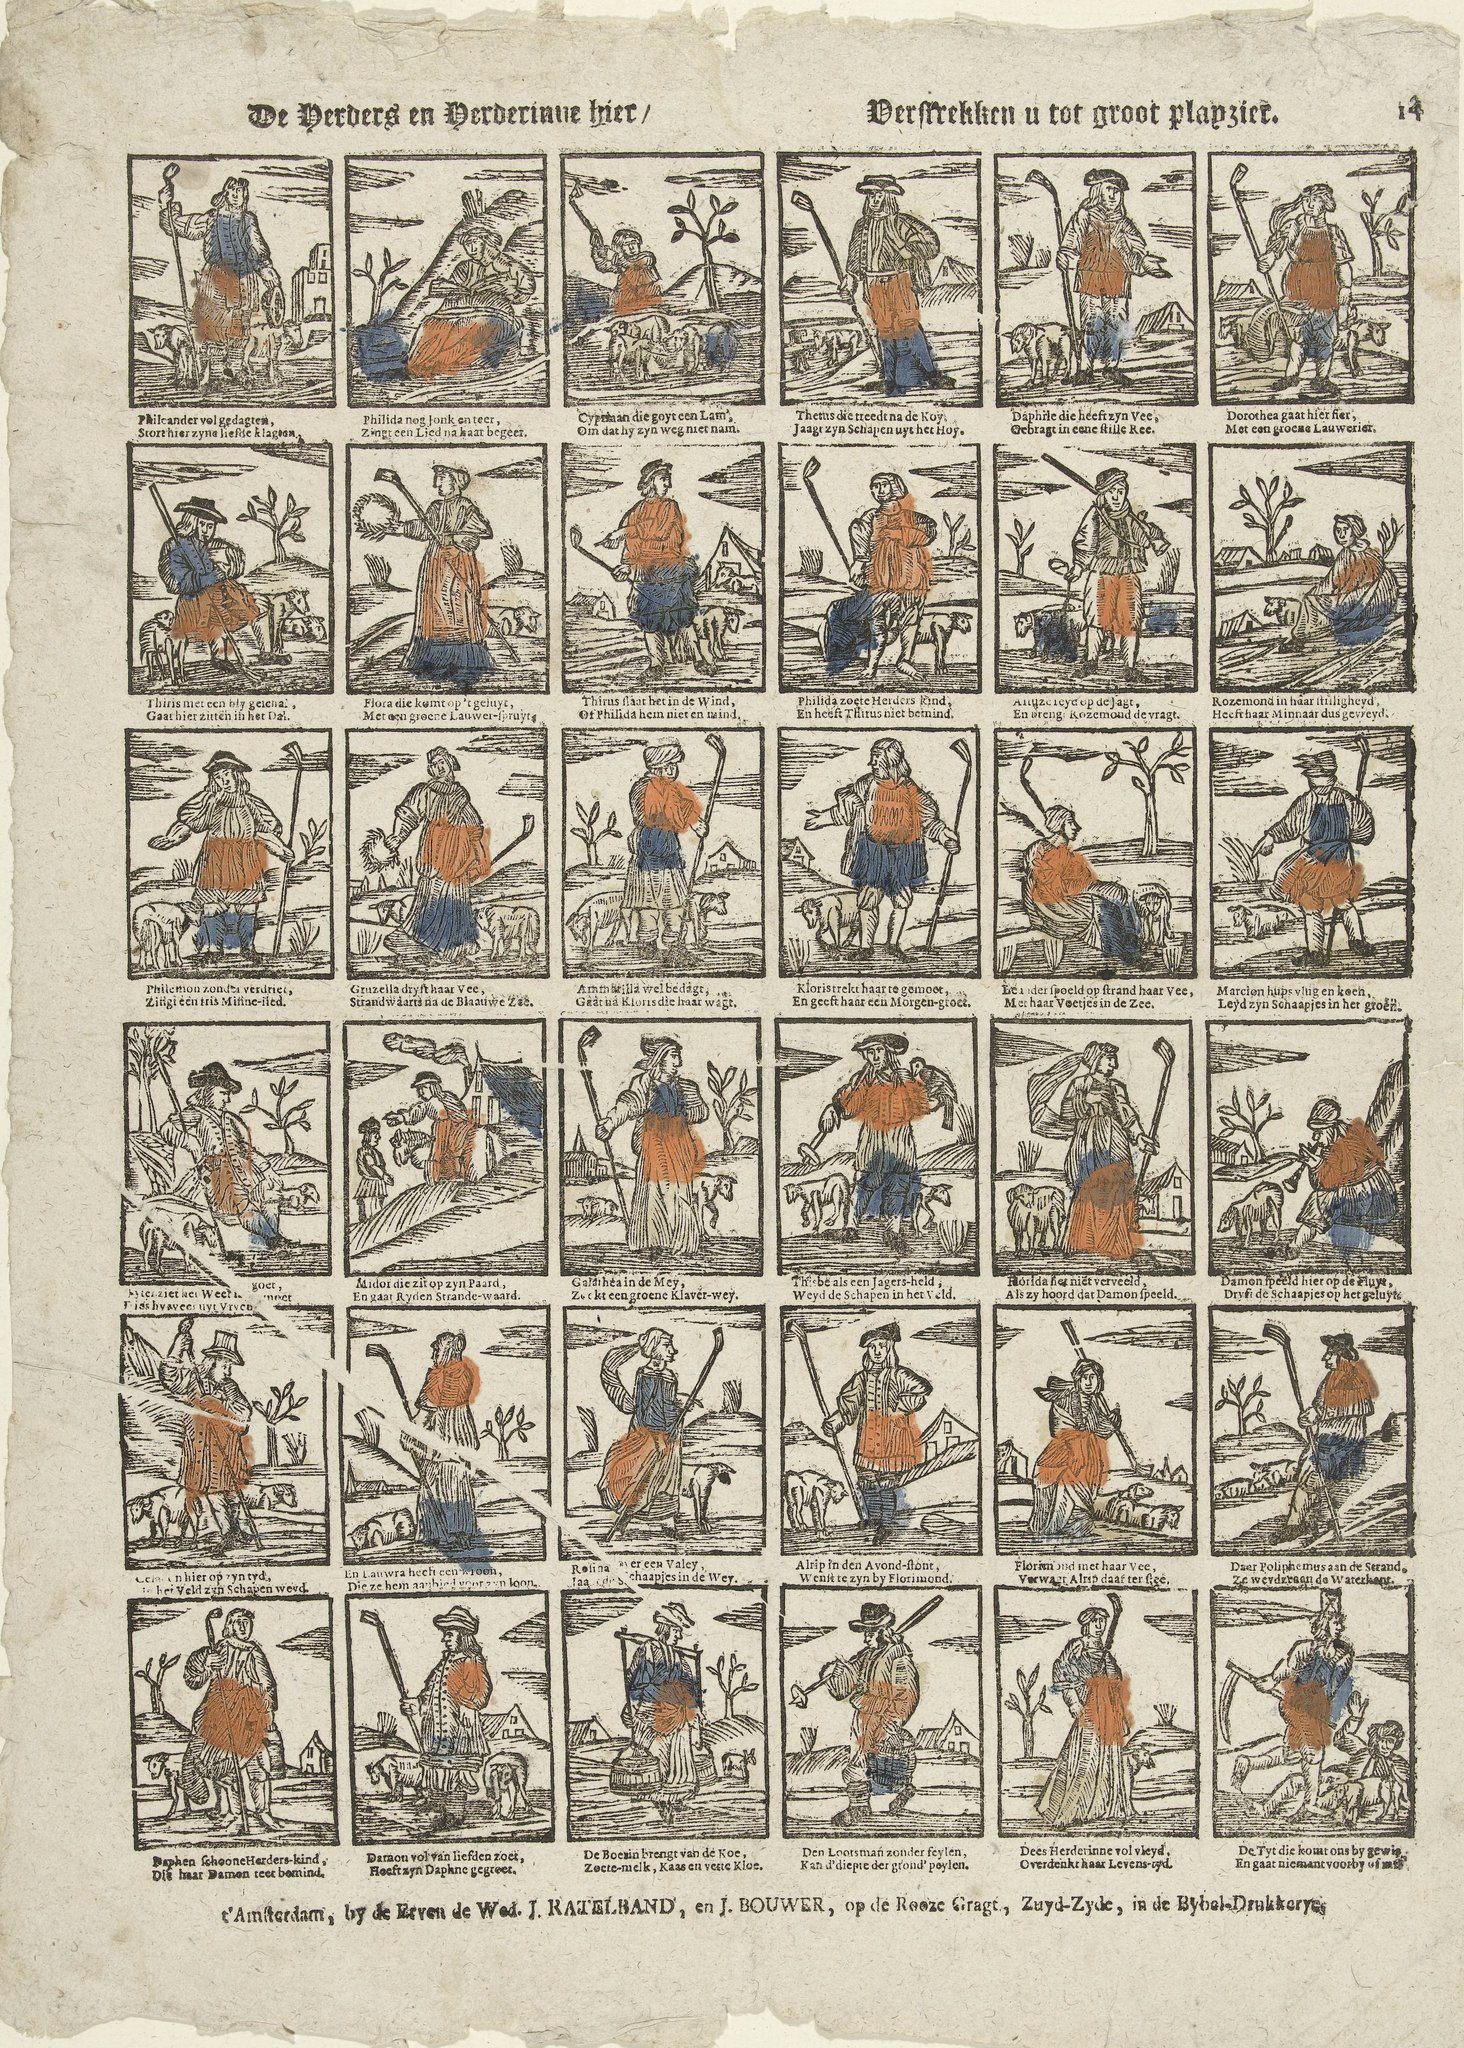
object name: print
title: De herders en herderinne hier / Verstrekken u tot groot playzier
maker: Anonymous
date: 1782-1793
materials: paper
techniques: colour, letterpress printing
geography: amsterdam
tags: herding, herdsman, herdswoman, shepherd, shepherdess, cowherd, etc., pastorals, arcadian scenes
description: Blad met 36 voorstellingen van herders en herderinnen. Onder elke afbeelding een tweeregelig vers waarin de herder of herderin met naam wordt genoemd. Genummerd rechtsboven: 14.